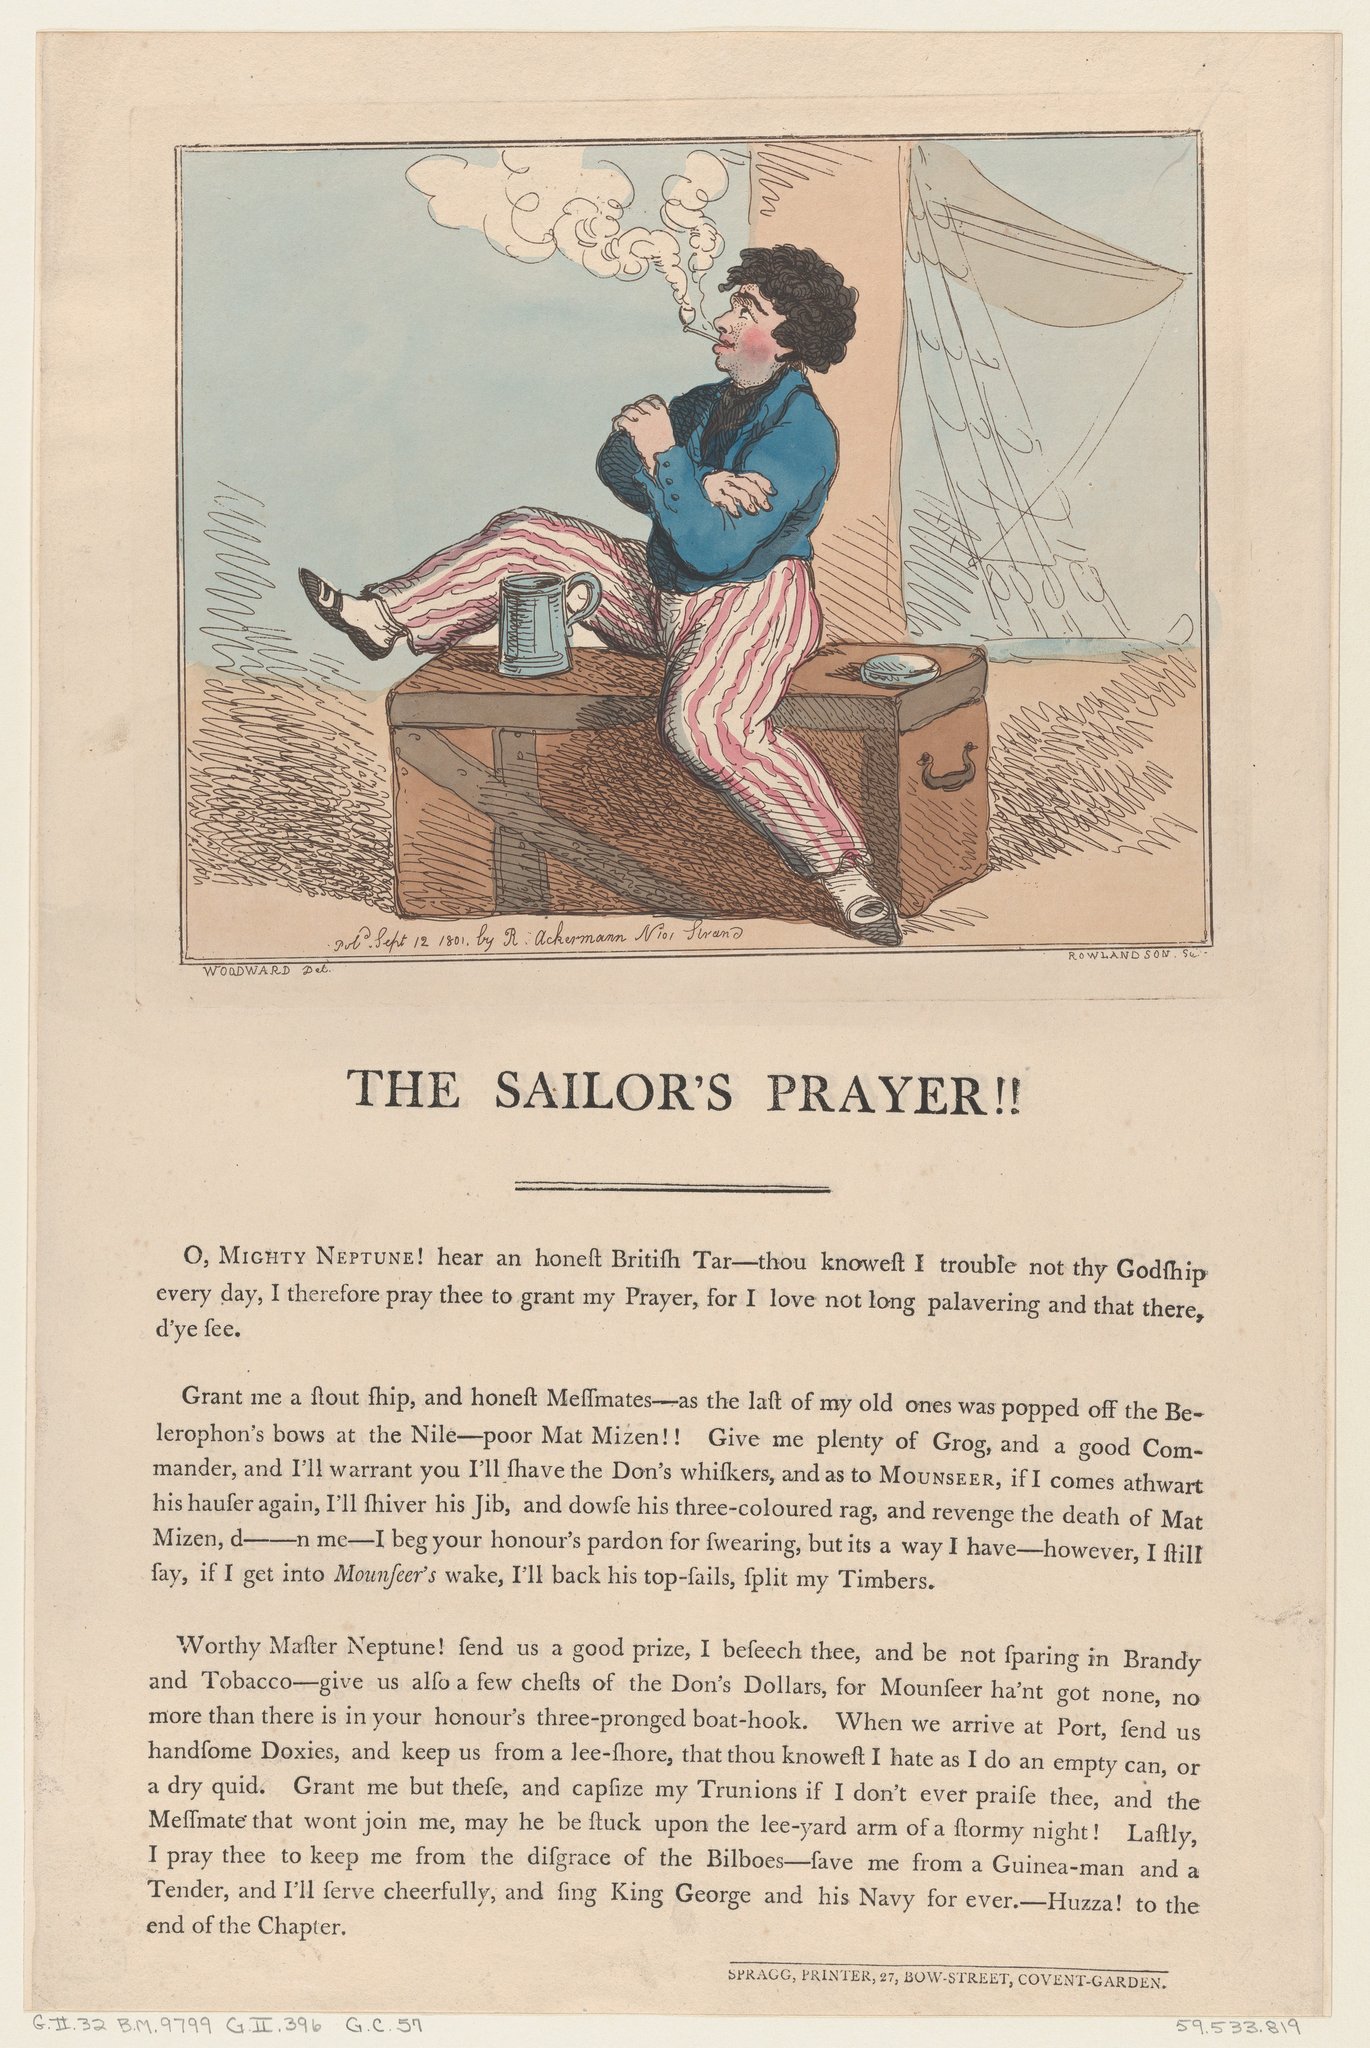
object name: print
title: The Sailor's Prayer!!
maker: thomas rowlandson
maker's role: artist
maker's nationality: british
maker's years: 1757-1827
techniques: etching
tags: men,smoking,sailors